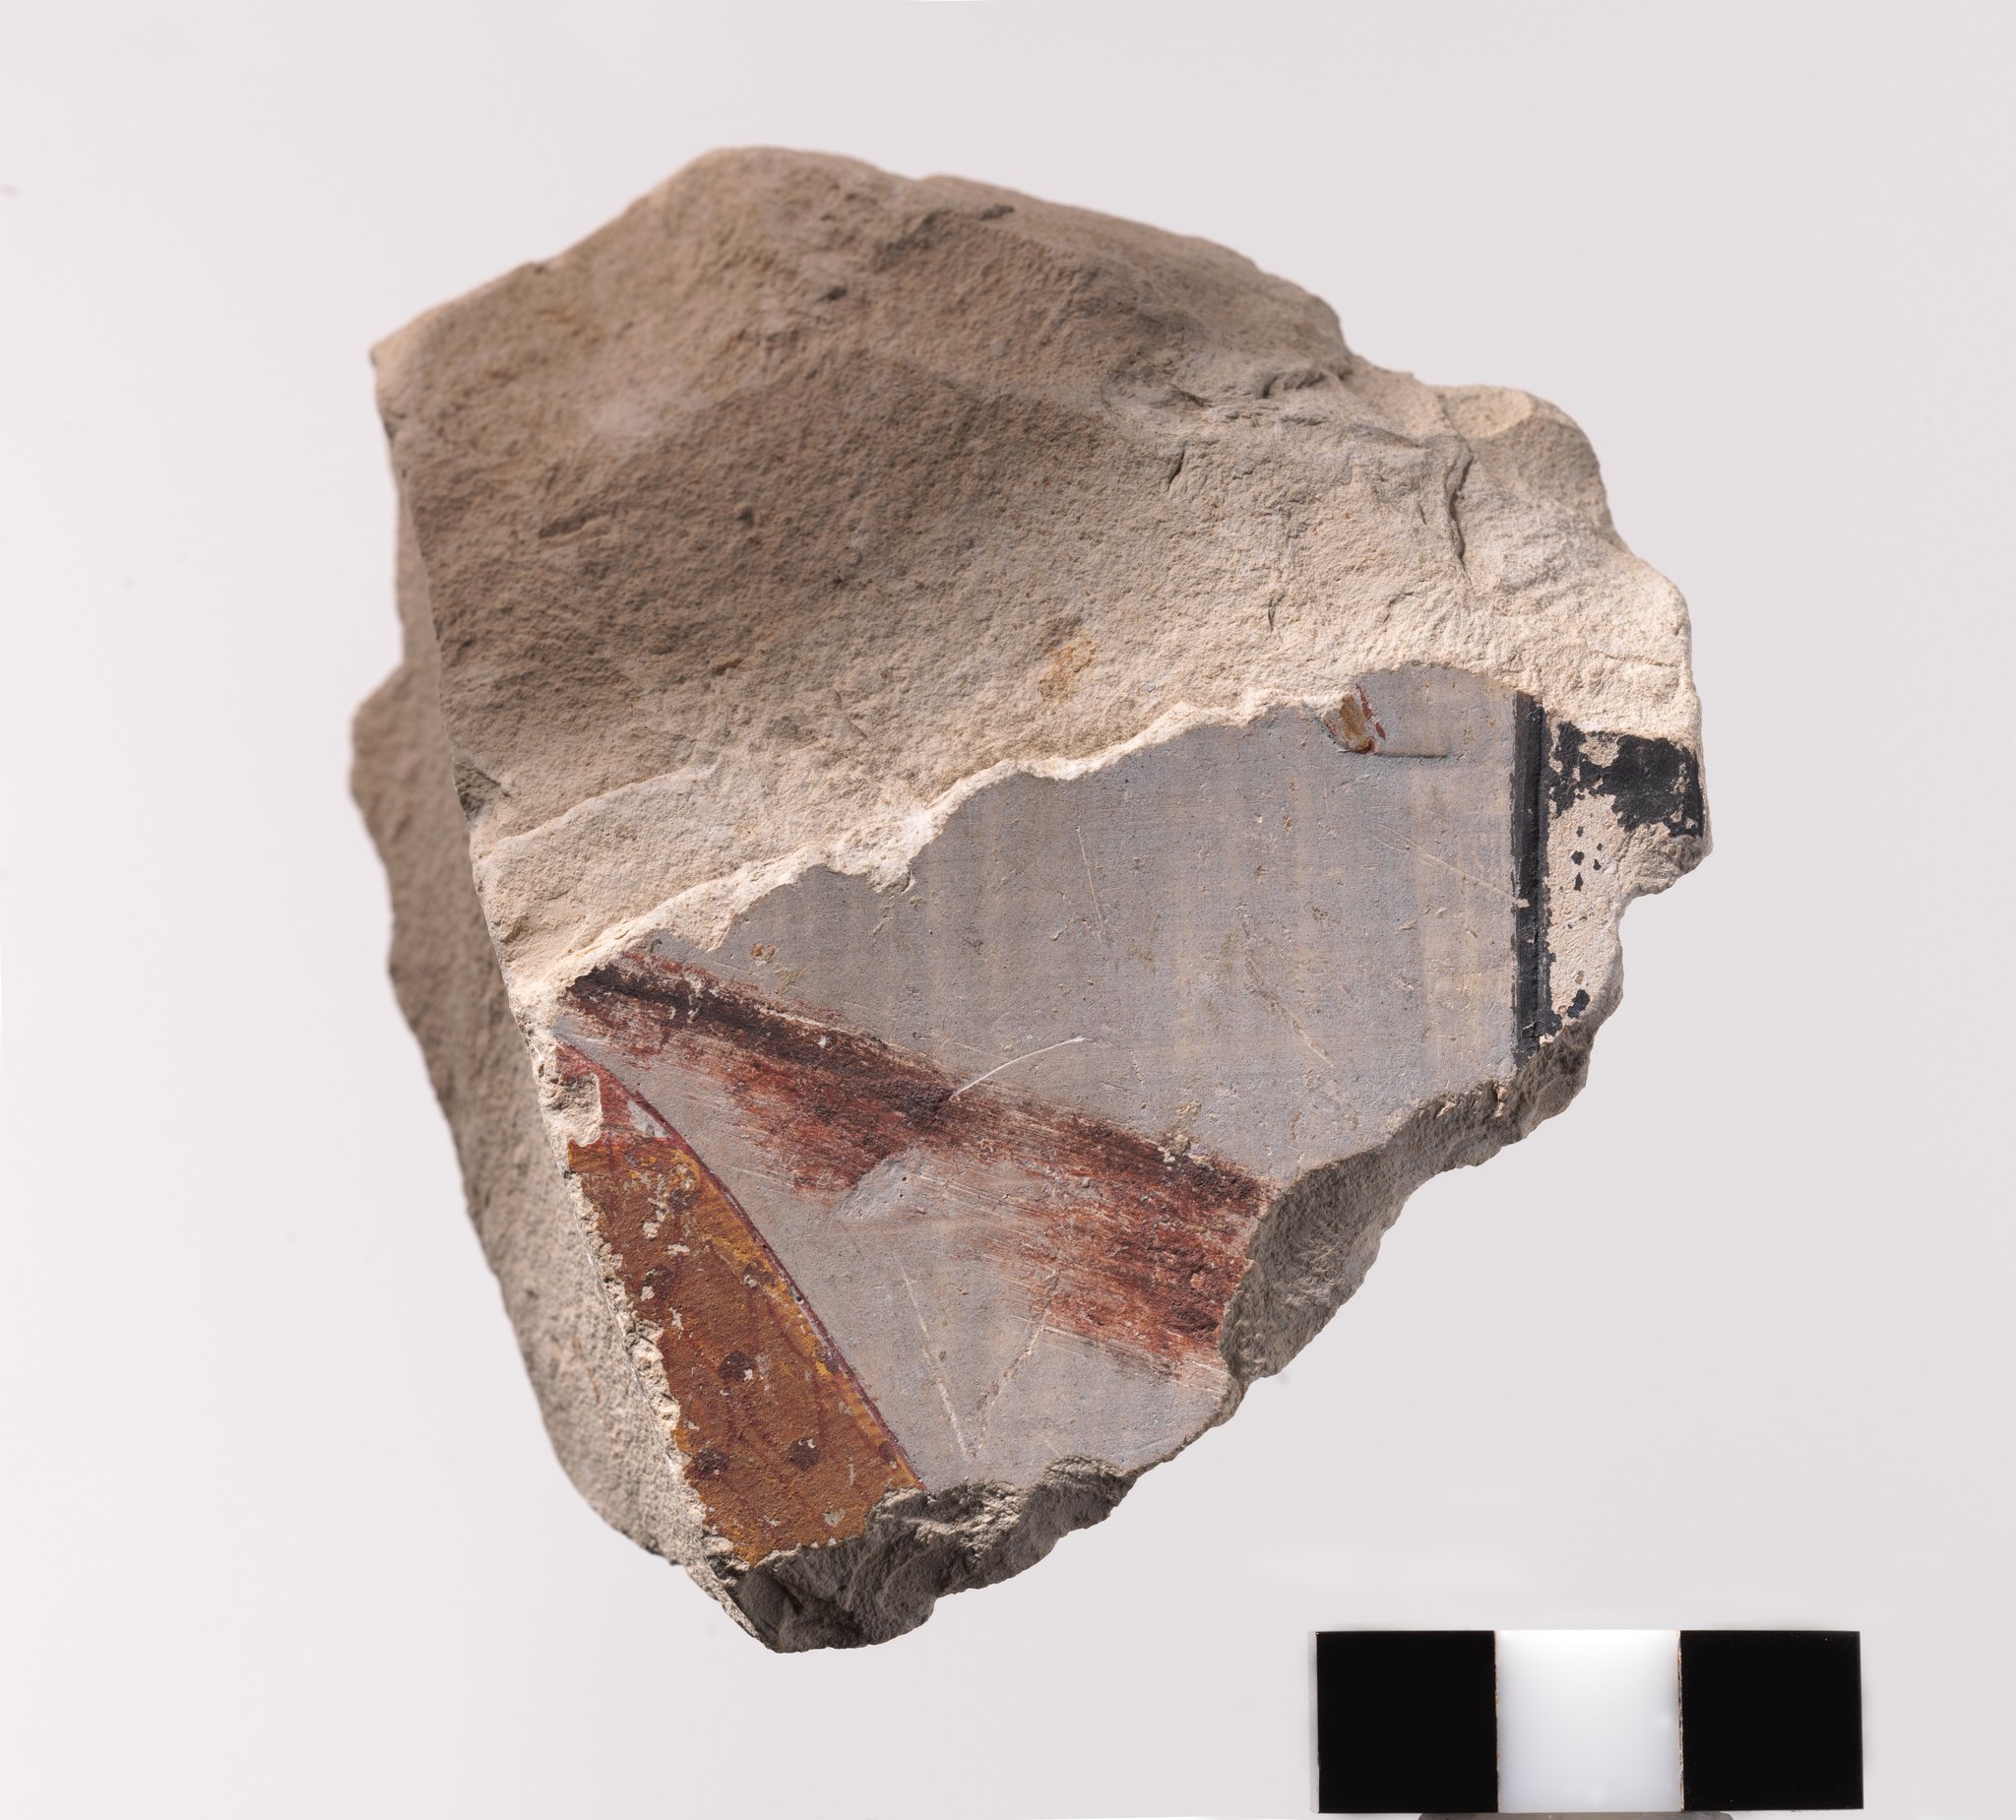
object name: relief fragment, tomb of meketre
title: Relief Fragment with Part of a Hieroglyph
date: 1981-1975 BCE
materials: limestone, paint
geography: egypt